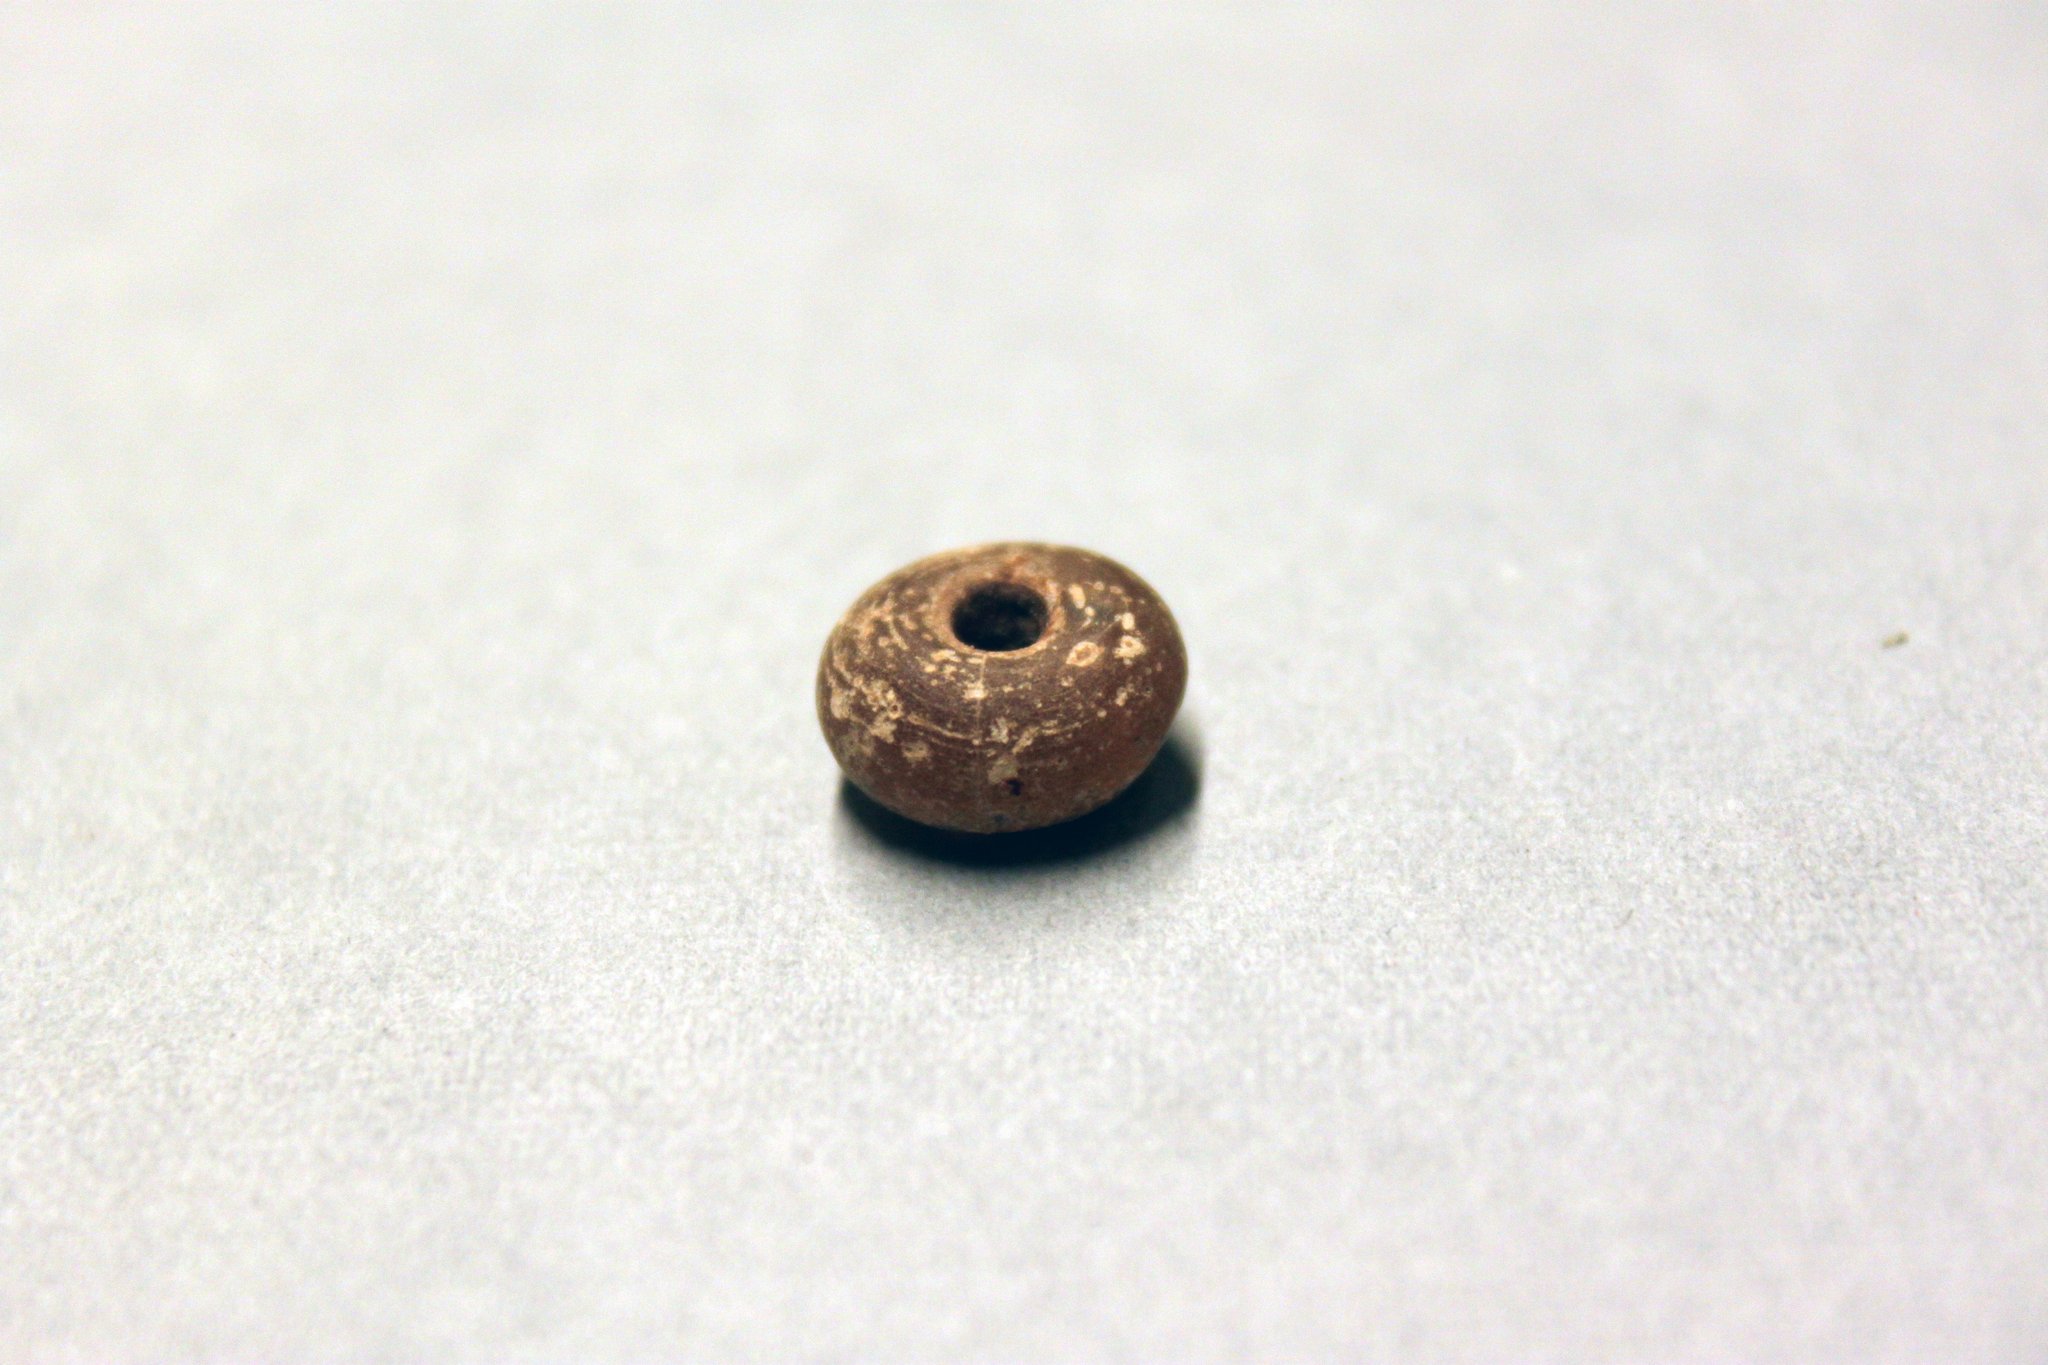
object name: bead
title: Beads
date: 701-1300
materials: glass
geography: iran